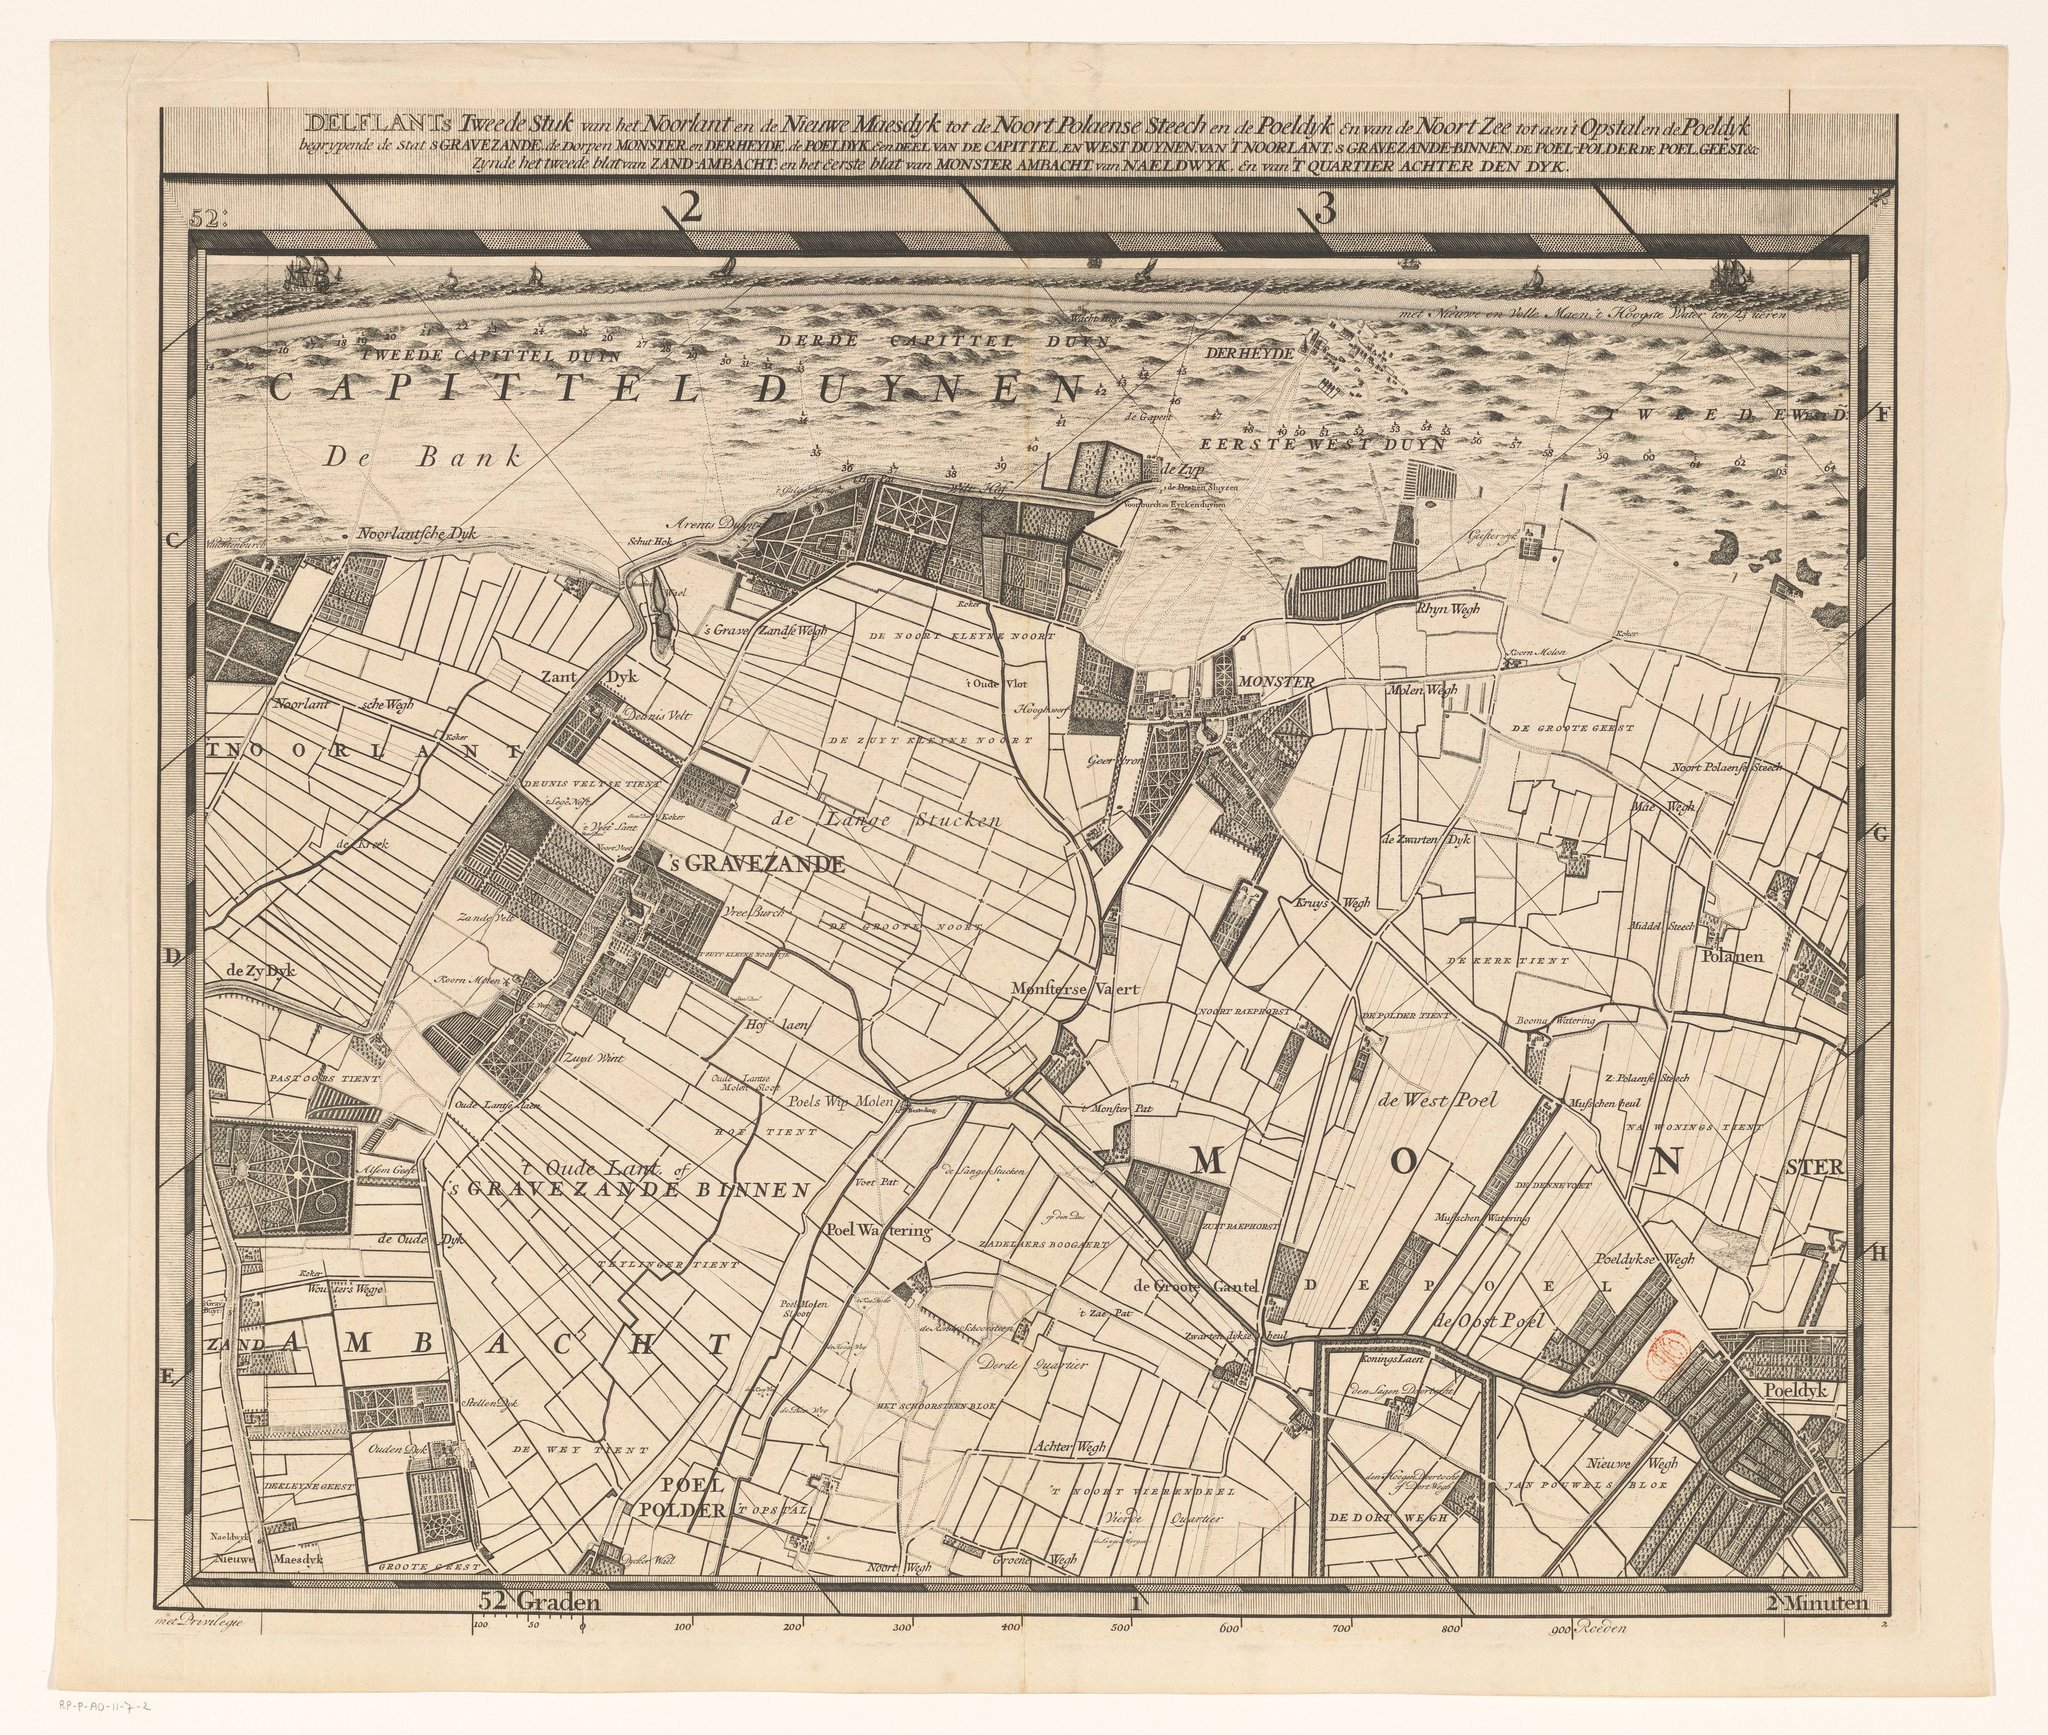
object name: map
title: 'T Hooge Heemraedschap van Delflant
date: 1712-1735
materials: paper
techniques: engraving, etching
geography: delft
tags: maps of cities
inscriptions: collector's mark: Lugt 195, collector's mark: Lugt 2228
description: Onderdeel van de grote wandkaart 'T Hooge Heemraedschap van Delflant. De kaart zelf bestaat uit vijfentwintig bladen, de titelstrook is gedrukt van twee platen. Meerdere prentmakers hebben aan deze kaart gewerkt. In volgorde van meest gewerkte dagen zijn dit: Luggert van Anse (1091 dagen), Thomas Doesburgh (952 dagen), Jacobus Deur (806 dagen), Johannes Deur (683 dagen) en Pieter Sluyter (151 dagen). Sluyter was verantwoordelijk voor de versieringen, de anderen voor de rest. Wie precies aan welk blad heeft gewerkt is niet duidelijk. Pieter Haringh had het ontwerp voor de wapenschilden geleverd en Arnold Houbraken het ontwerp voor de rest van de versieringen. Het drukken, uitgeven en verkopen van de kaart lag, zoals blijkt uit het privilege, in handen van het hoogheemraadschap. Voor zover bekend is de kaart in zijn geheel twee keer gedrukt, in 1712 en 1735. Het hoogheemraadschap beheerde de voorraad kaarten voor verkoop. In een aantal atlassen van Covens & Mortier (Nieuwe atlas inhoudende de vier gedeeltens der waereld (...). 5 delen. Amsterdam: Covens & Mortier, s.a. [1721-1759], dl. 3) zijn de zevenentwintig bladen van de kaart en de overzichtskaart opgenomen. Het is dus vermoedelijk niet zo dat de kaart voor deze atlassen opnieuw werd gedrukt. Waarschijnlijk werd een aantal exemplaren bij het hoogheemraadschap afgenomen.